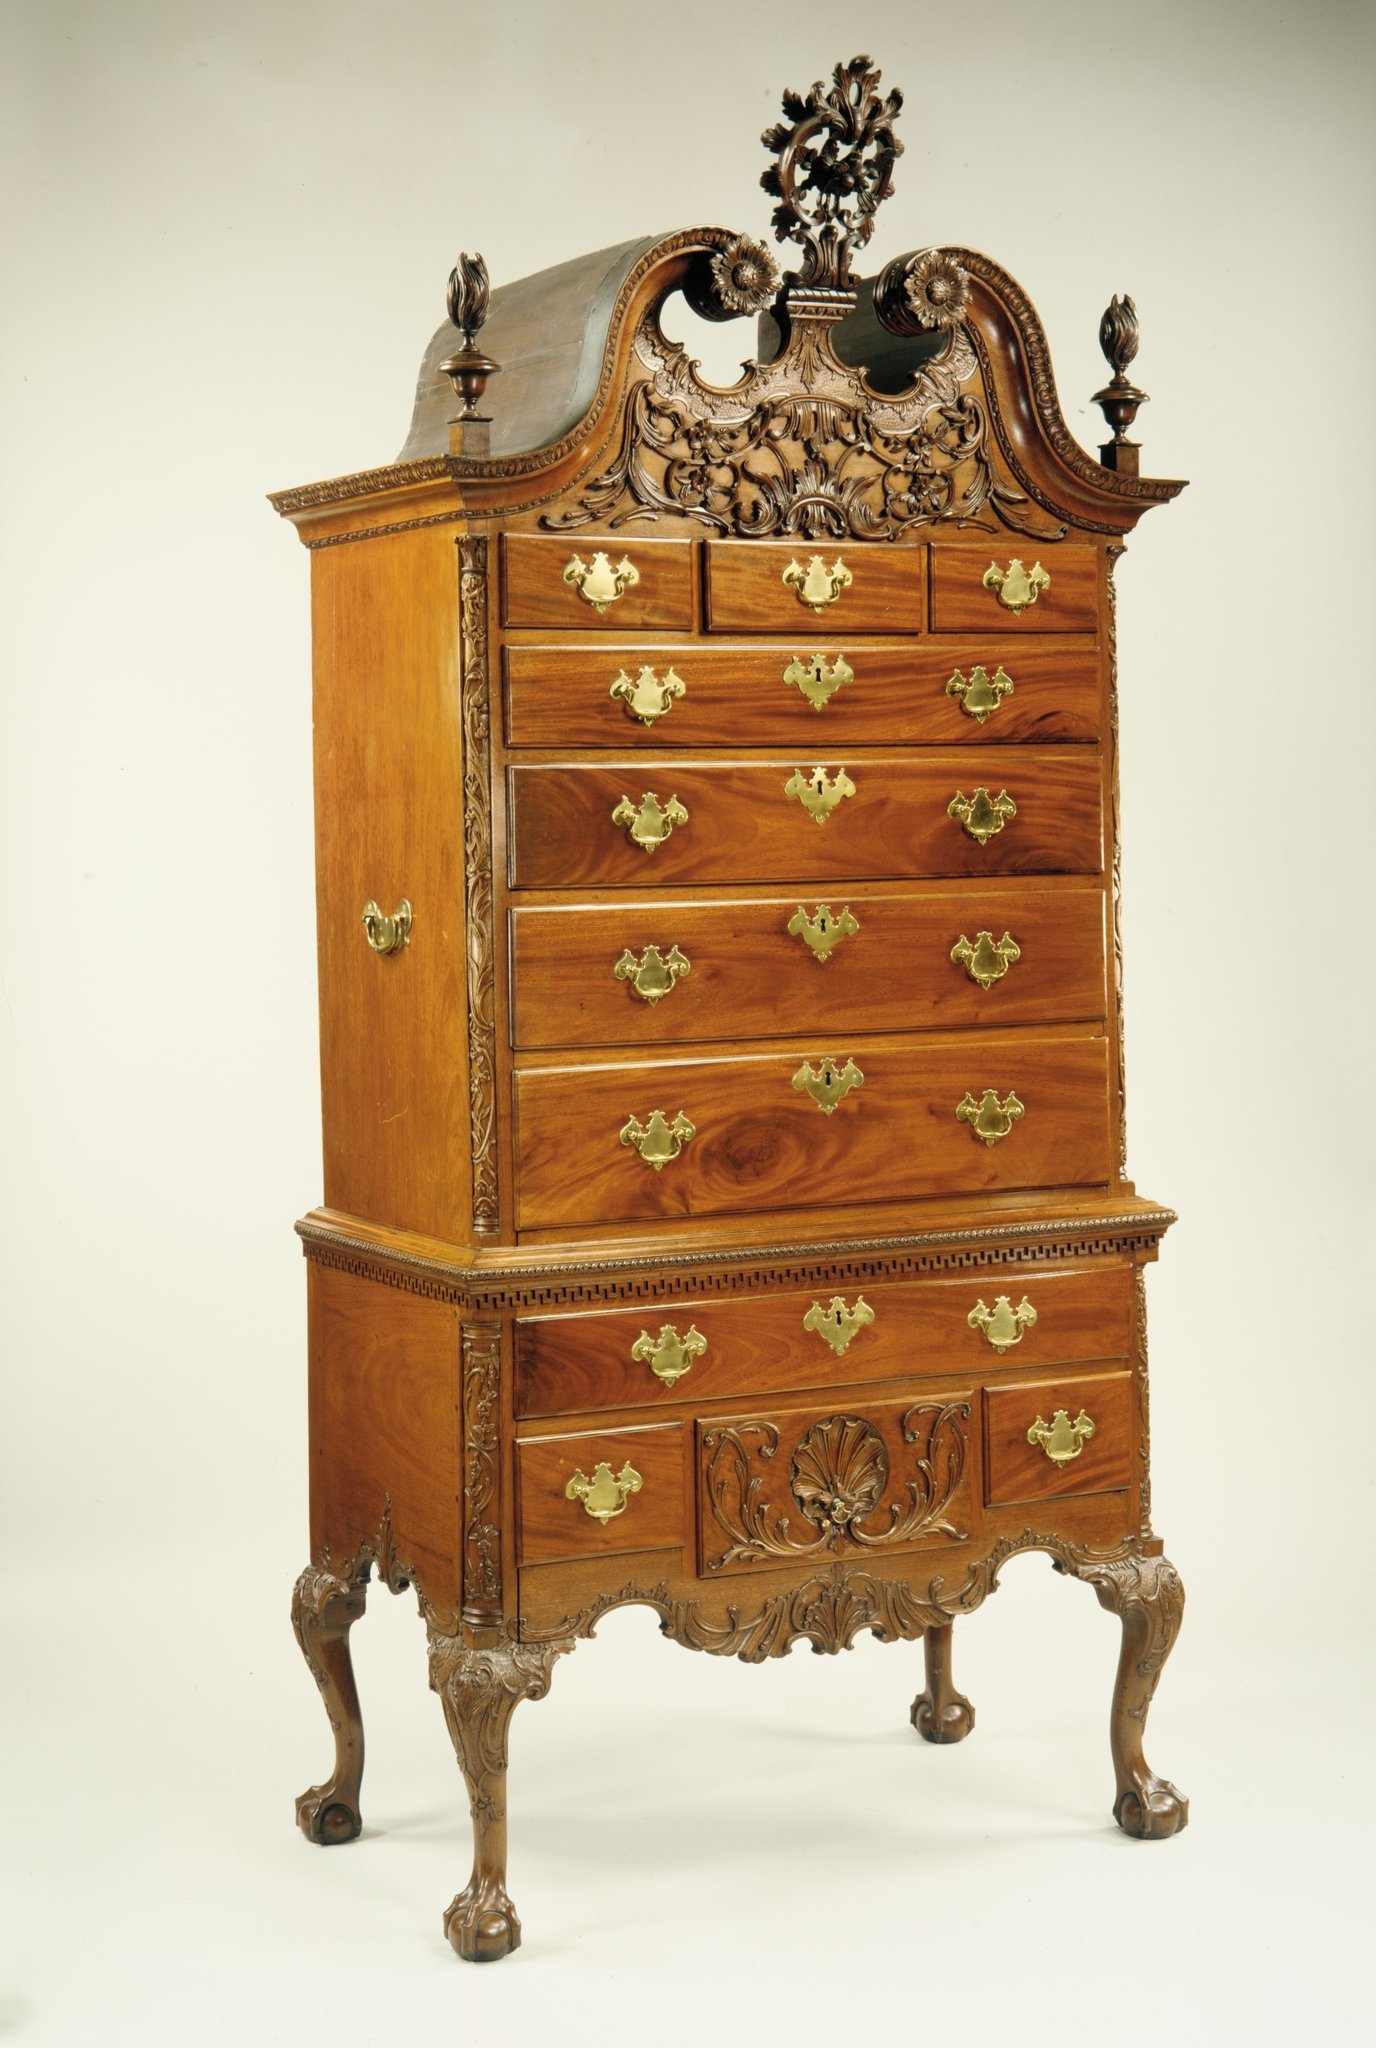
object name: high chest of drawer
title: High chest of drawers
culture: american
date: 1755-1790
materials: wood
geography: united states